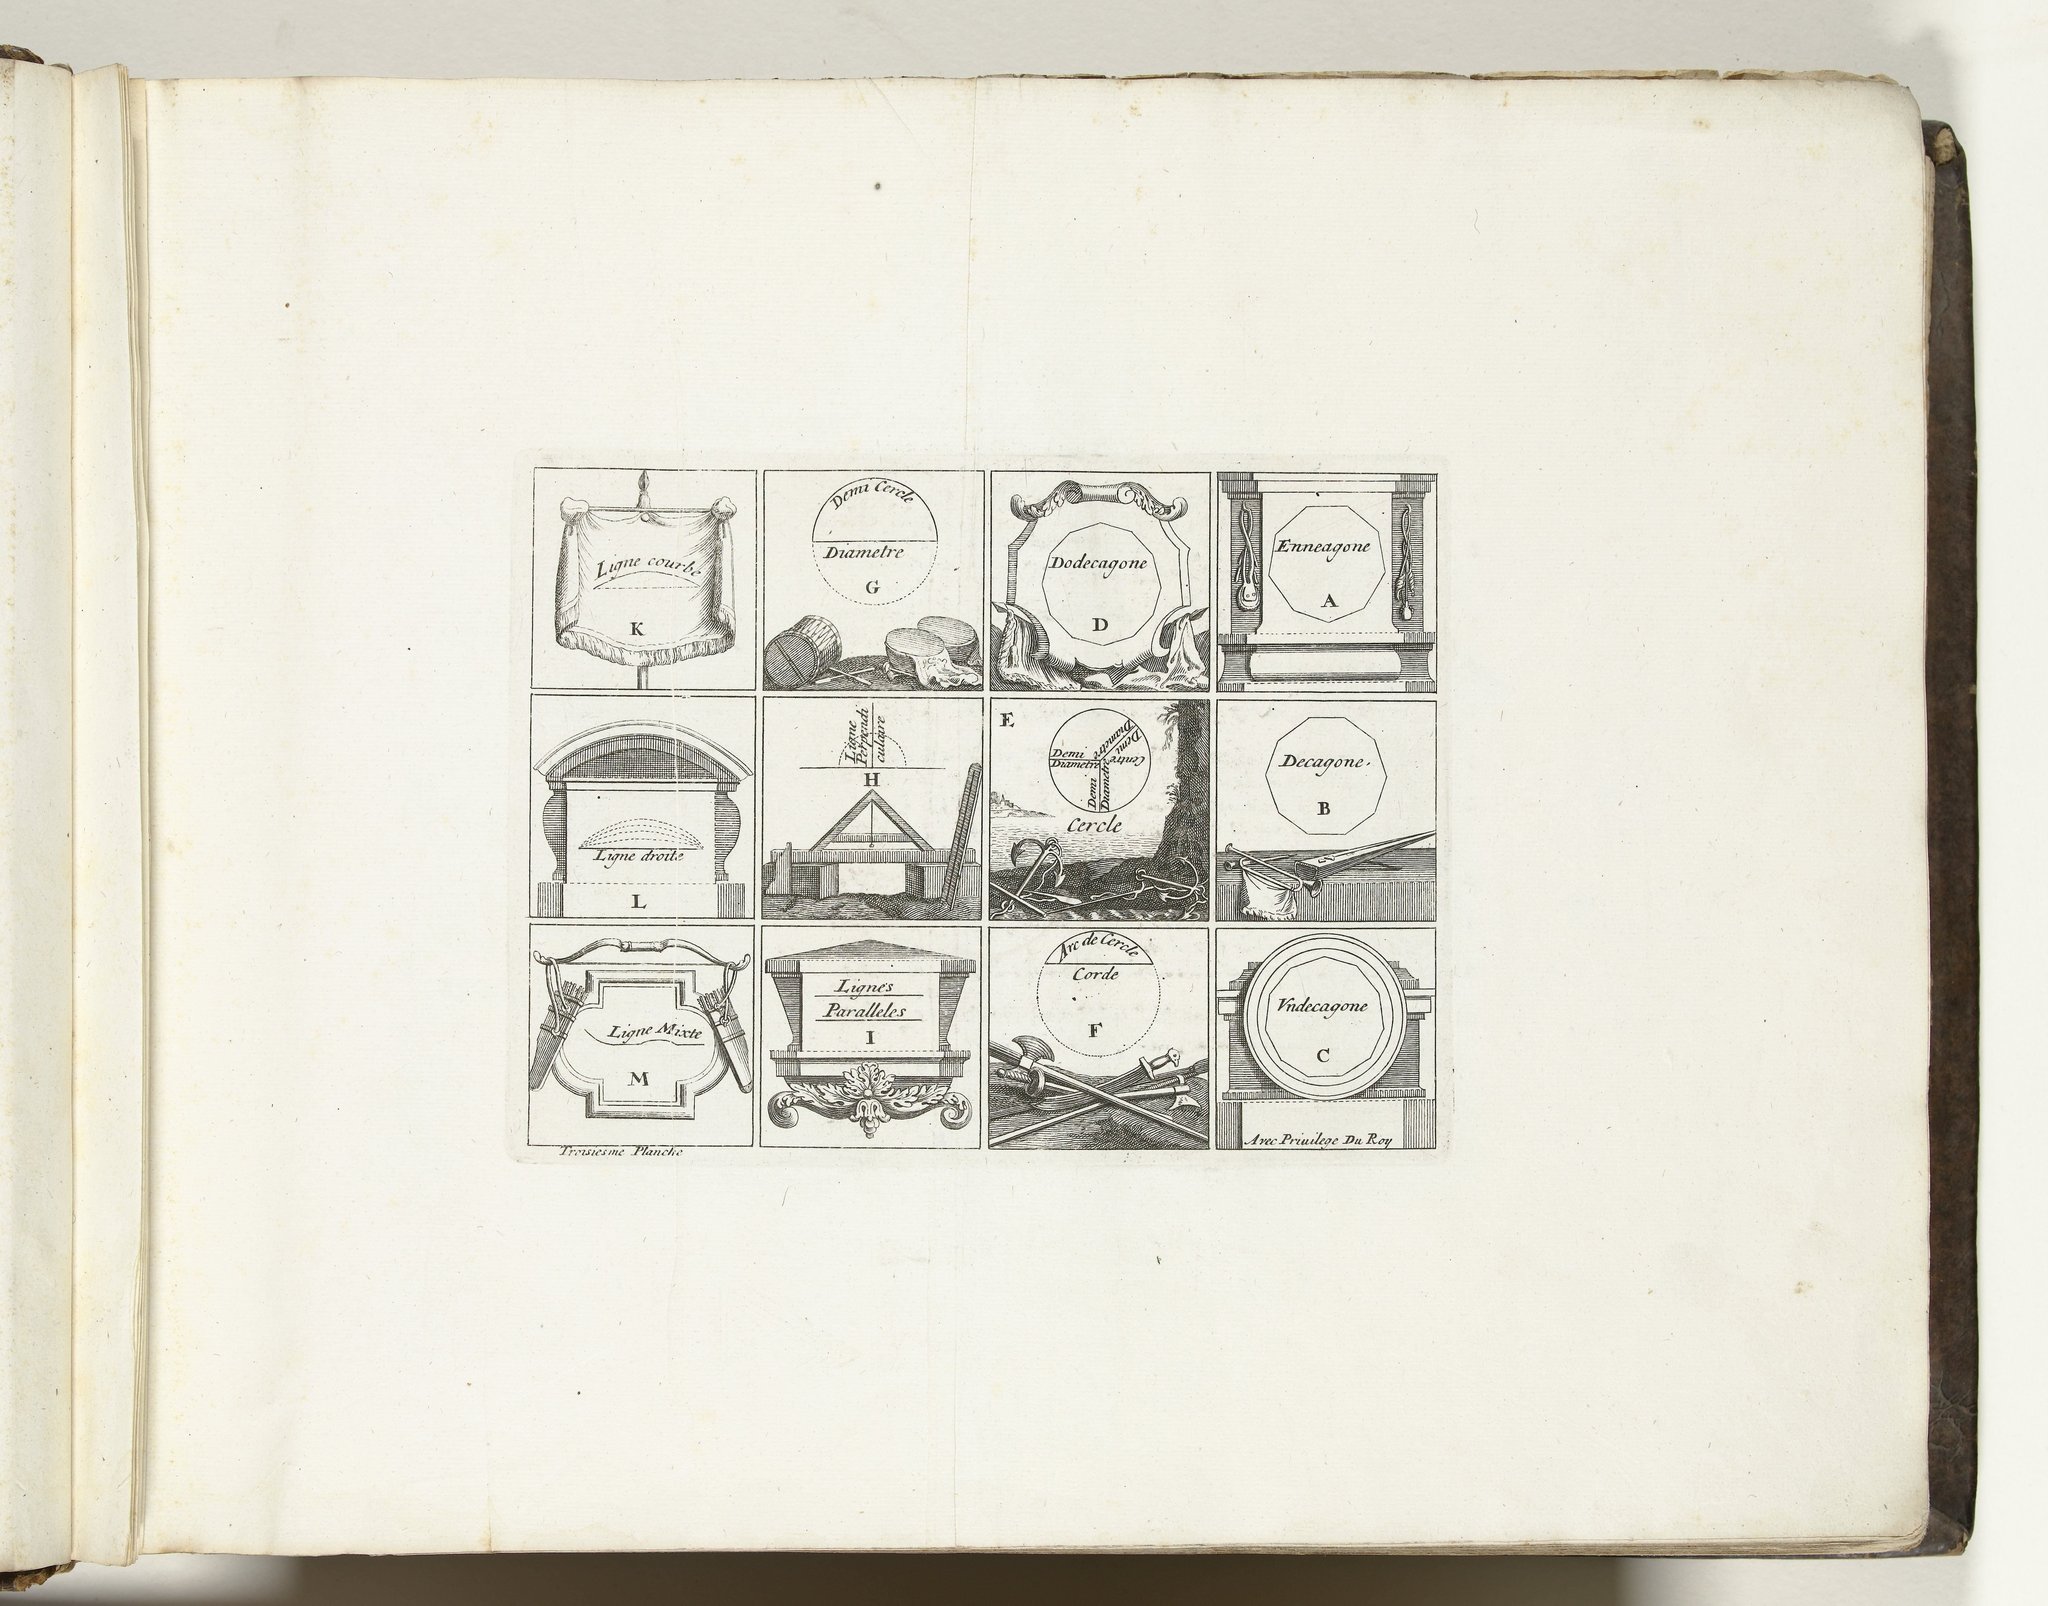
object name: print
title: Derde plaat met figuren in de vestingbouw, 1693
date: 1693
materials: paper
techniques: engraving, etching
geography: france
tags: fortifications, military engineering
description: Derde plaat met geometrische figuren toegepast in de vestingbouw. Onderdeel van het eerste deel (1693) van het prentwerk waarin gebundeld zijn de acht delen van Les forces de l'Europe uitgegeven tussen 1693-1697. Het prentwerk bestaat uit 175 platen met plannen (afkomstig van Sébastien Le Prestre, Seigneur de Vauban) van vermaarde sterke steden en vestingen in de Negenjarige Oorlog. Titel in het Frans.